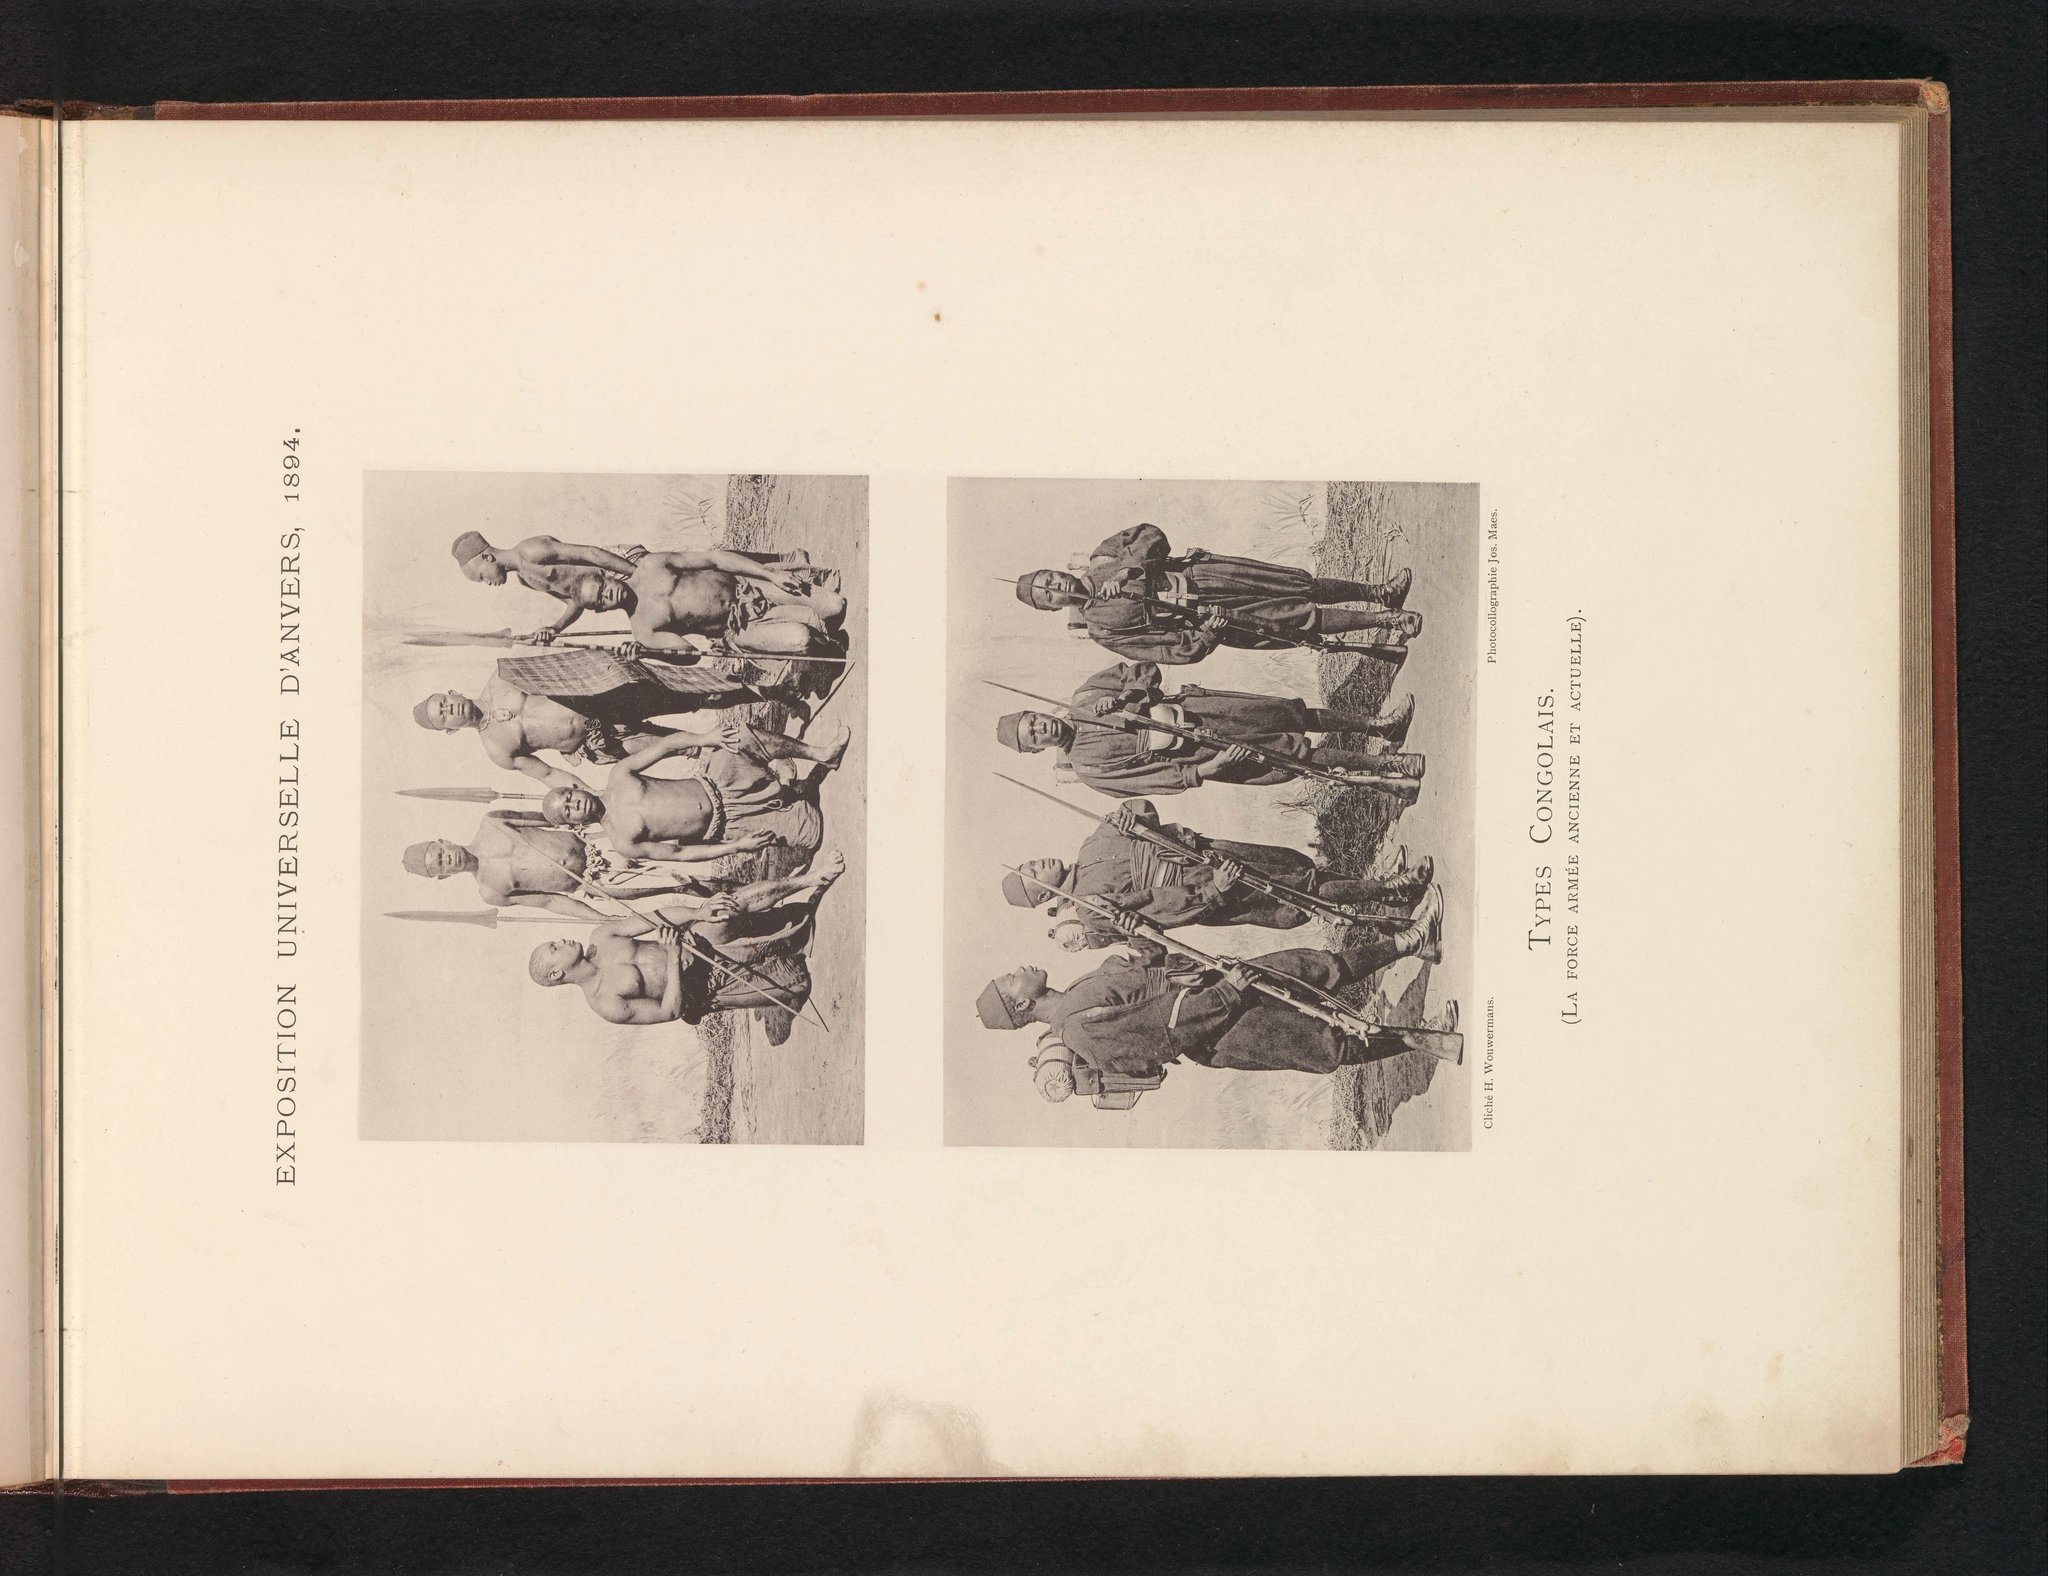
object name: page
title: Types Congolais (La force armée ancienne et actuelle)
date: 1894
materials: paper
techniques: photograph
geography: antwerp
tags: casting weapons: spear, firearms: rifle, (military) uniforms, anonymous historical persons portrayed in a group, in a group-portrait